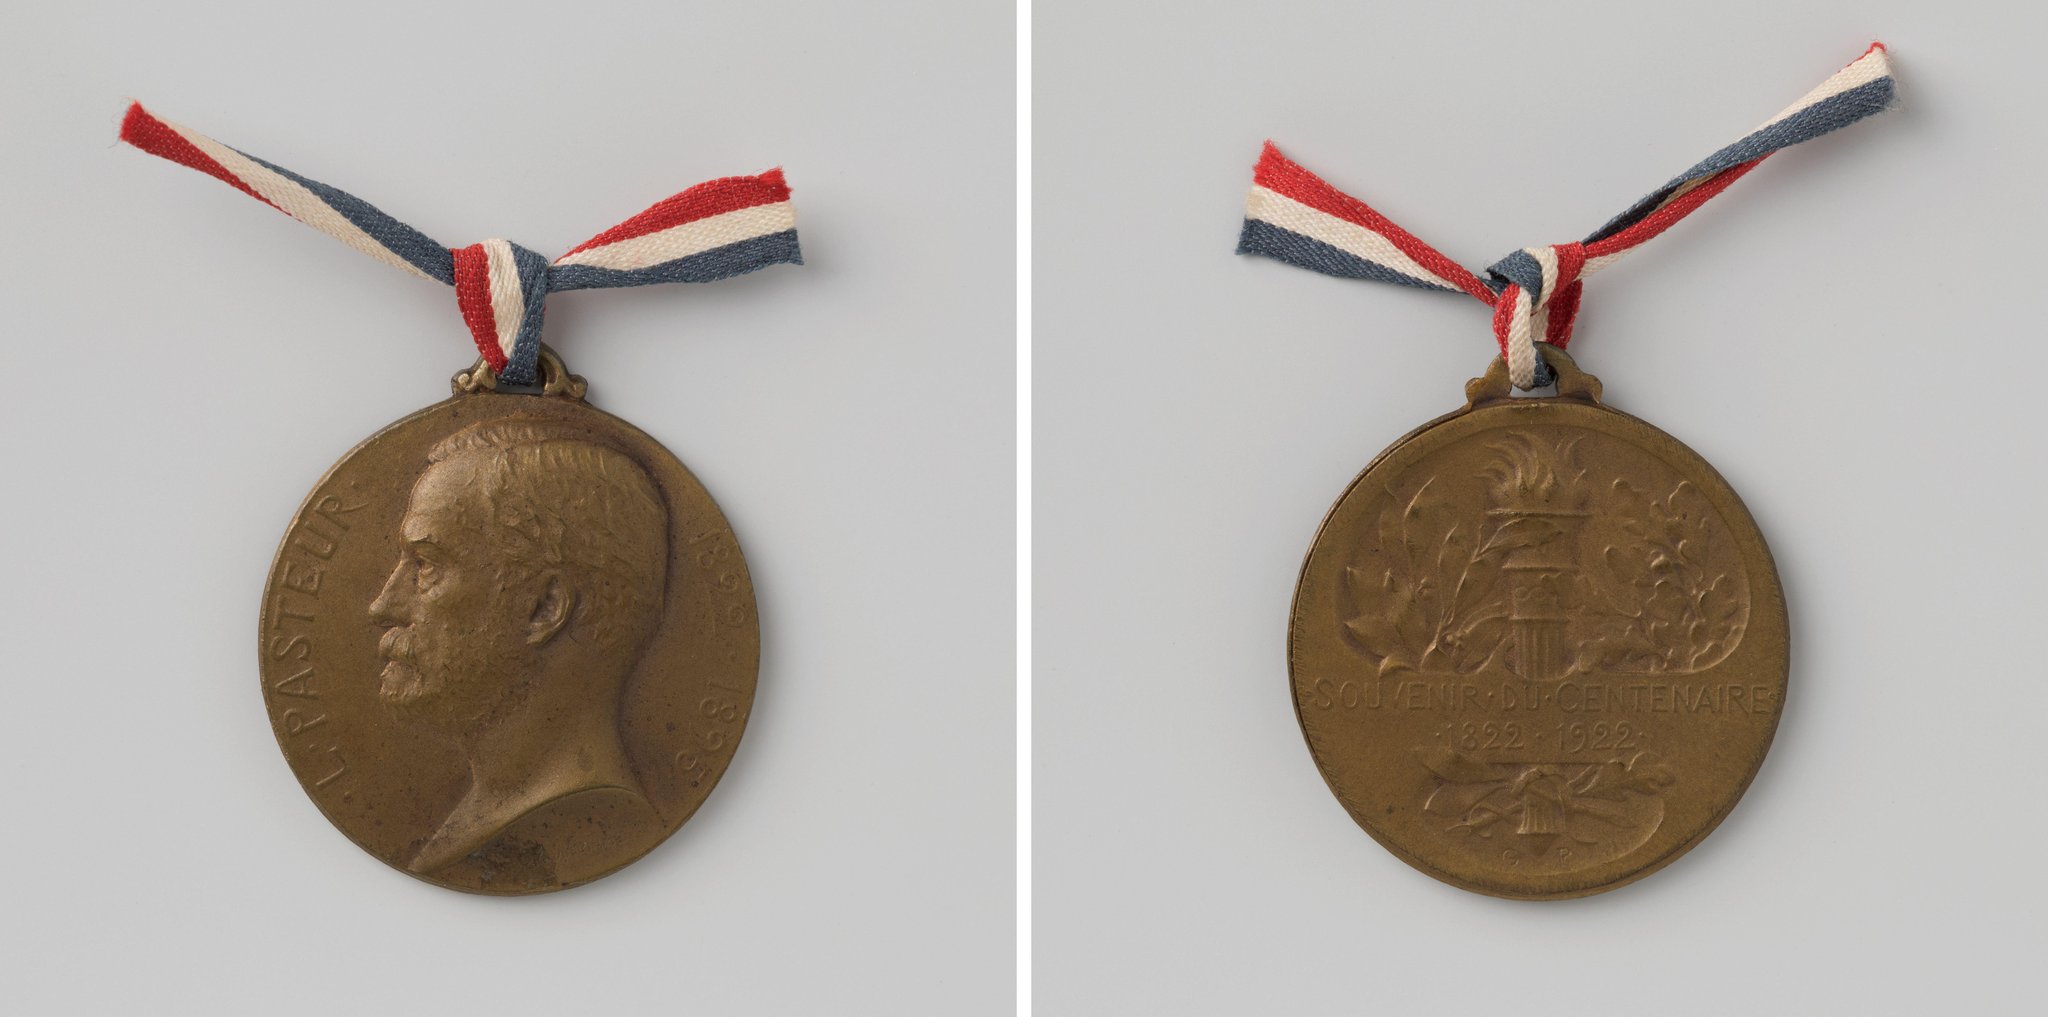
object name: history medal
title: Honderdjarige herdenking van de geboorte van Louis Pasteur 1922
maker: georges-henri prudhomme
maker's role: modelleur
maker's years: 1873-1947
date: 1922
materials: bronze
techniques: striking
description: Bronzen penning met draagoog aan rood-wit-blauwe strik, op de voorzijde het portret van Pasteur naar links met omschrift, op de keerzijde een toorts tussen een lauwer- en een eikentak binnen een rand die in het midden in een balk met drie regels tekst uitloopt.